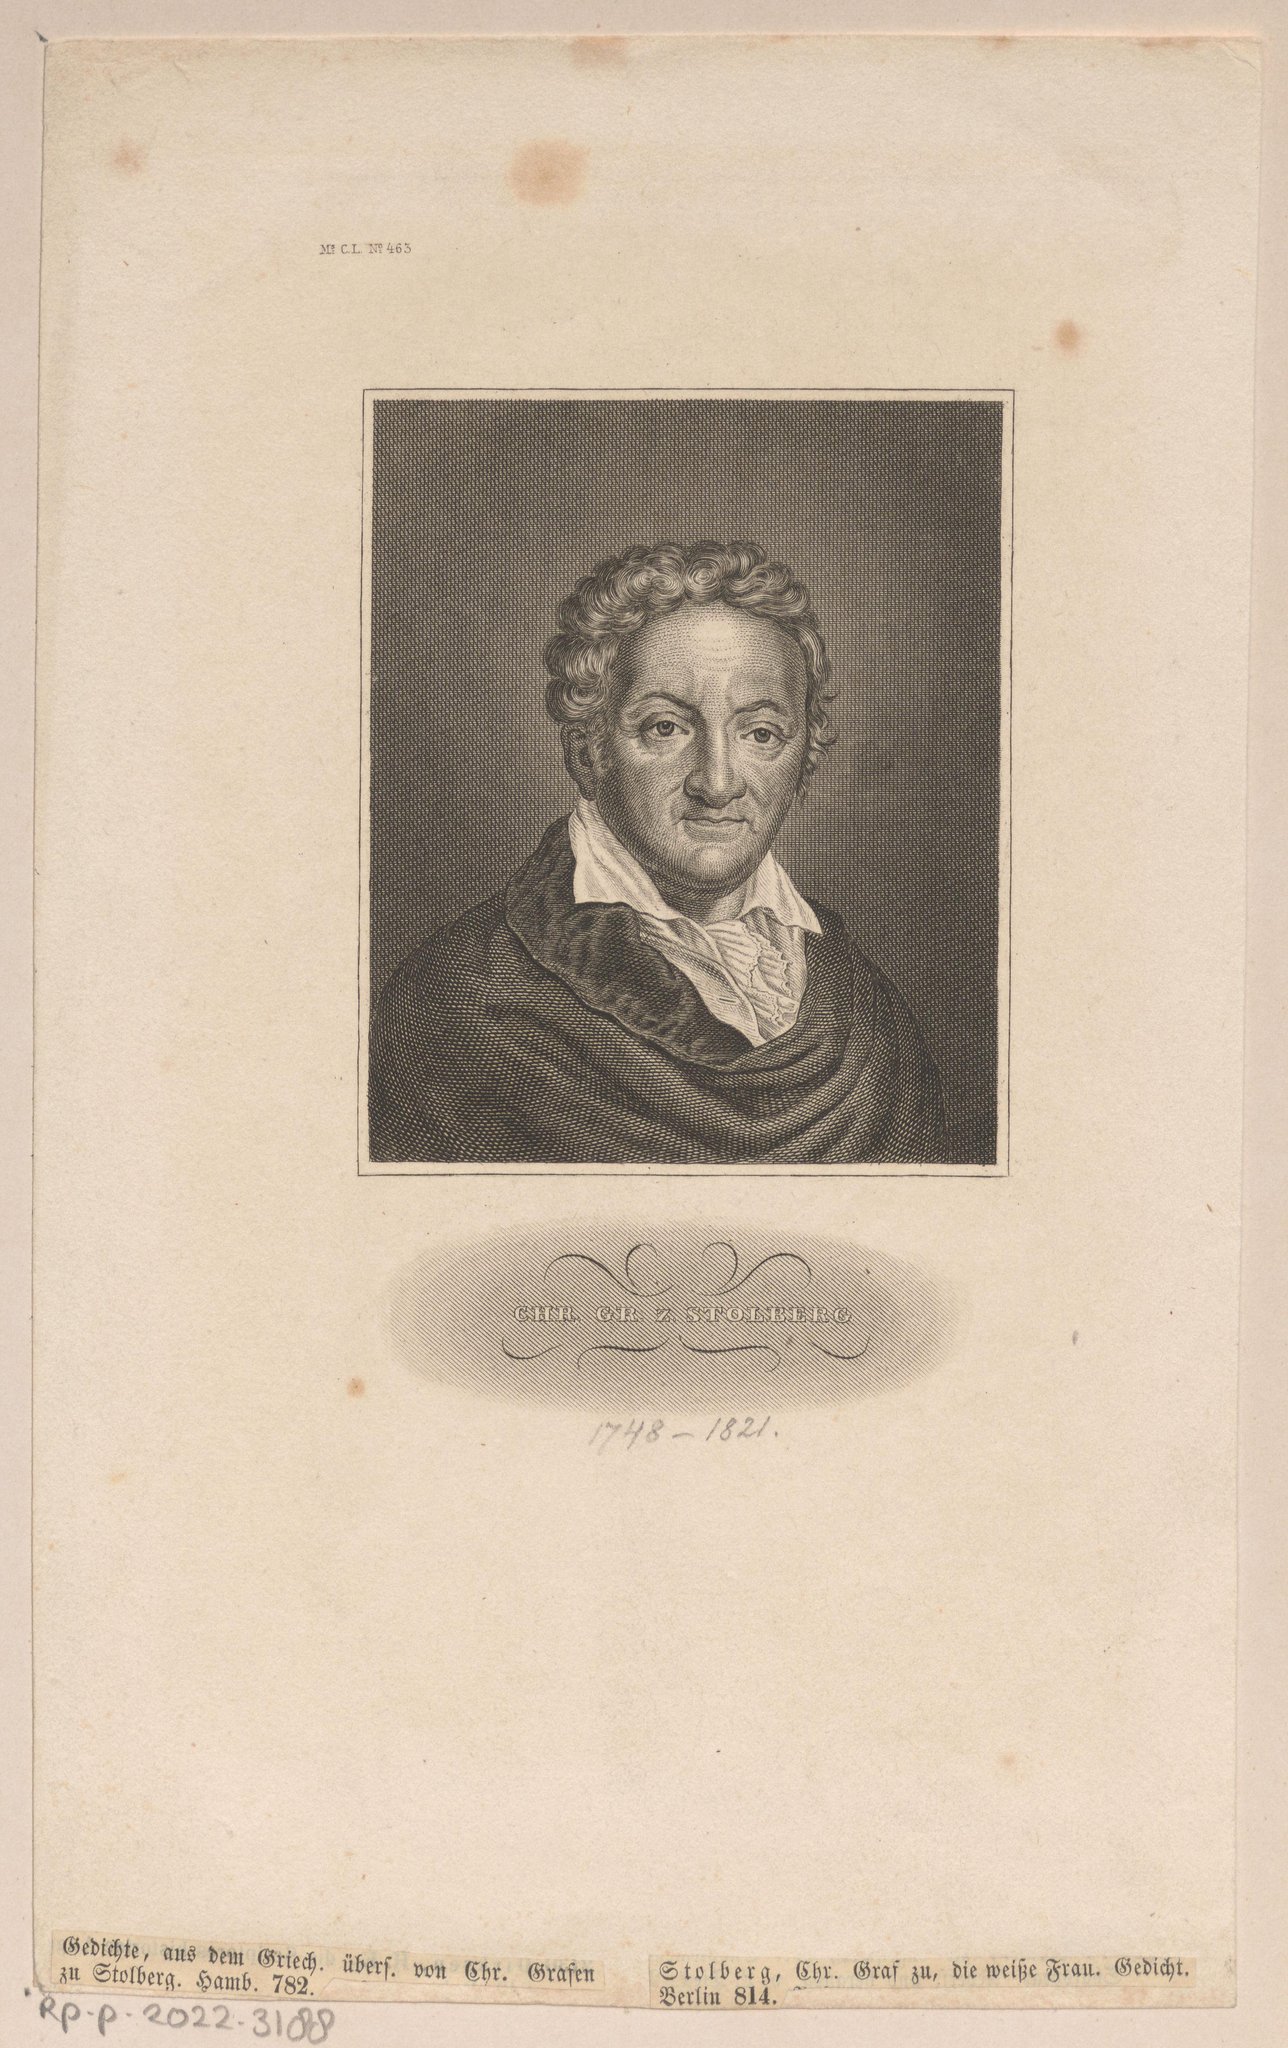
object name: book illustration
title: Portret van Christian Graf zu Stolberg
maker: Anonymous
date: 1840-1855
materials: paper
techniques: engraving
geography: hildburghausen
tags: historical persons, writer, poet, author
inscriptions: inscription: ‘Gedichte, aus dem (...) Gedicht. / Berlin 814.’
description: Prent uit: Meyer, Joseph. Conversations-Lexikon für die gebildeten Stände. Hildburghausen: Bibliographisches Institut, [1840-1855].